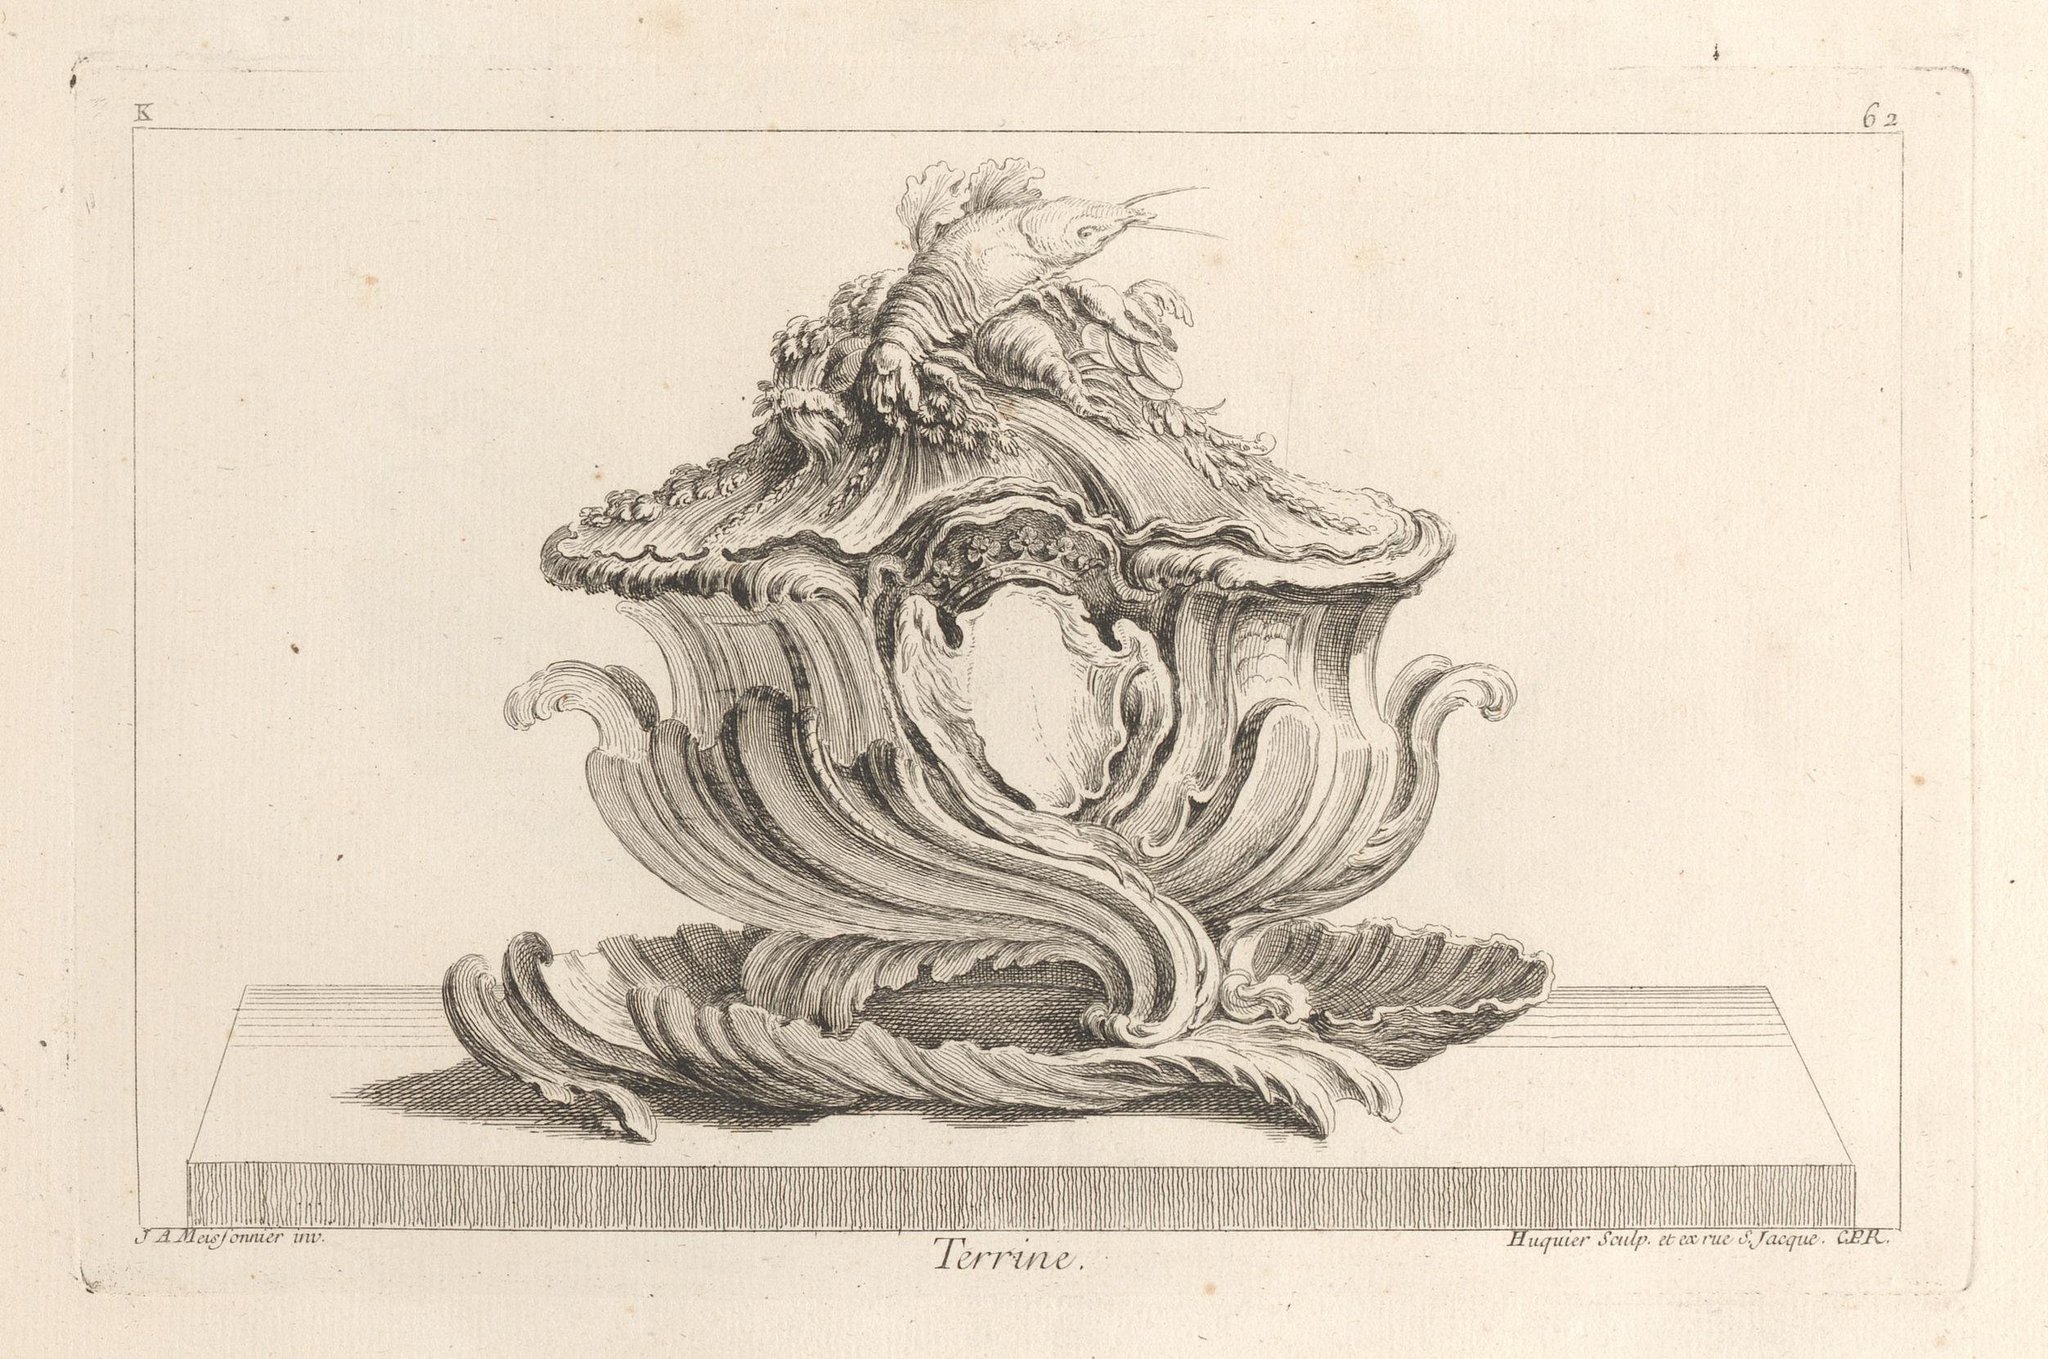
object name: album leaf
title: Terrine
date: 1738-1749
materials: paper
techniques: etching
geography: paris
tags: serving-dish, platter, work of applied art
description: Deze prent maakt deel uit van de serie "Dixieme livre des oeuvres de J.A. Messonnier", een van de delen van de monumentale reeks "Oeuvre de Juste Aurele Meissonnier".